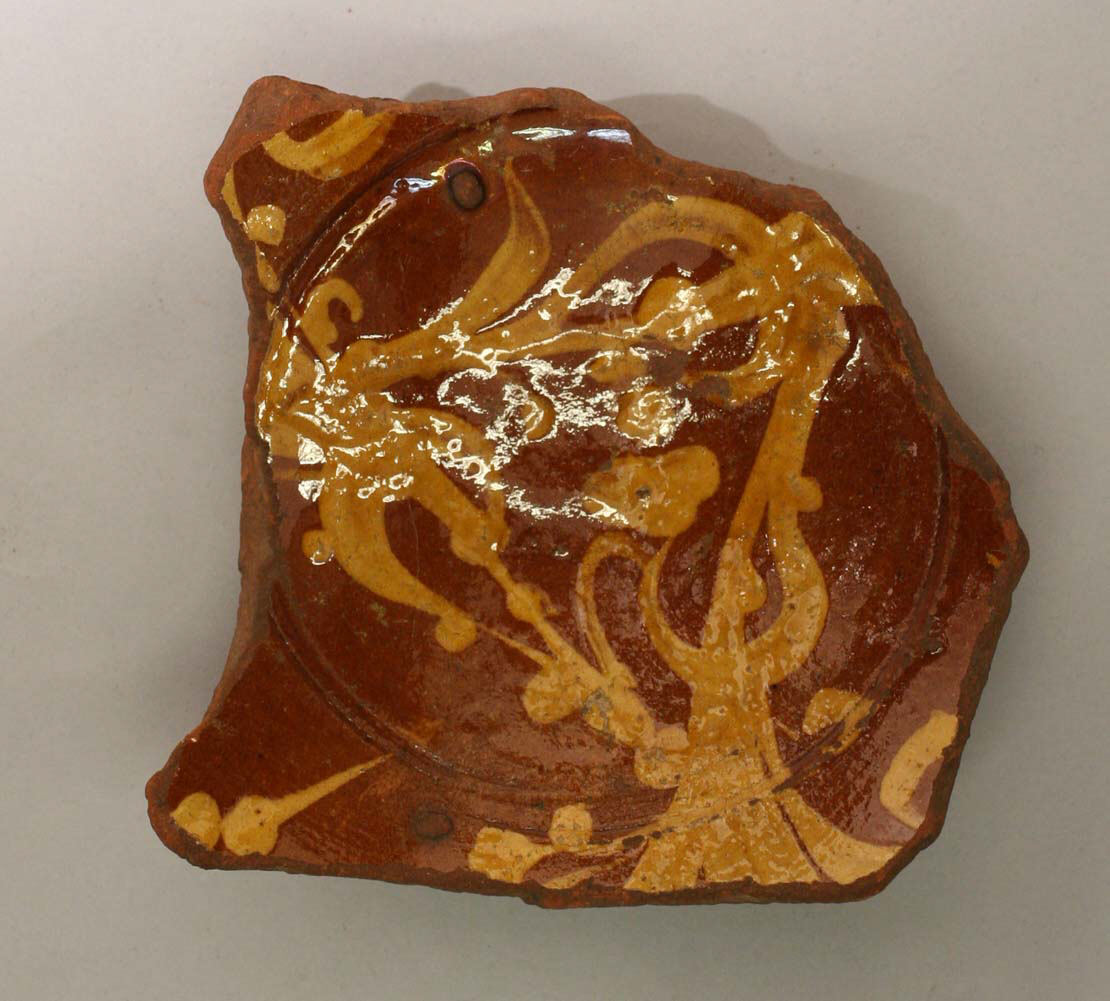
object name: fragment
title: Fragment of a Bowl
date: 1301-1500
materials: earthenware, glaze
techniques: painting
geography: egypt